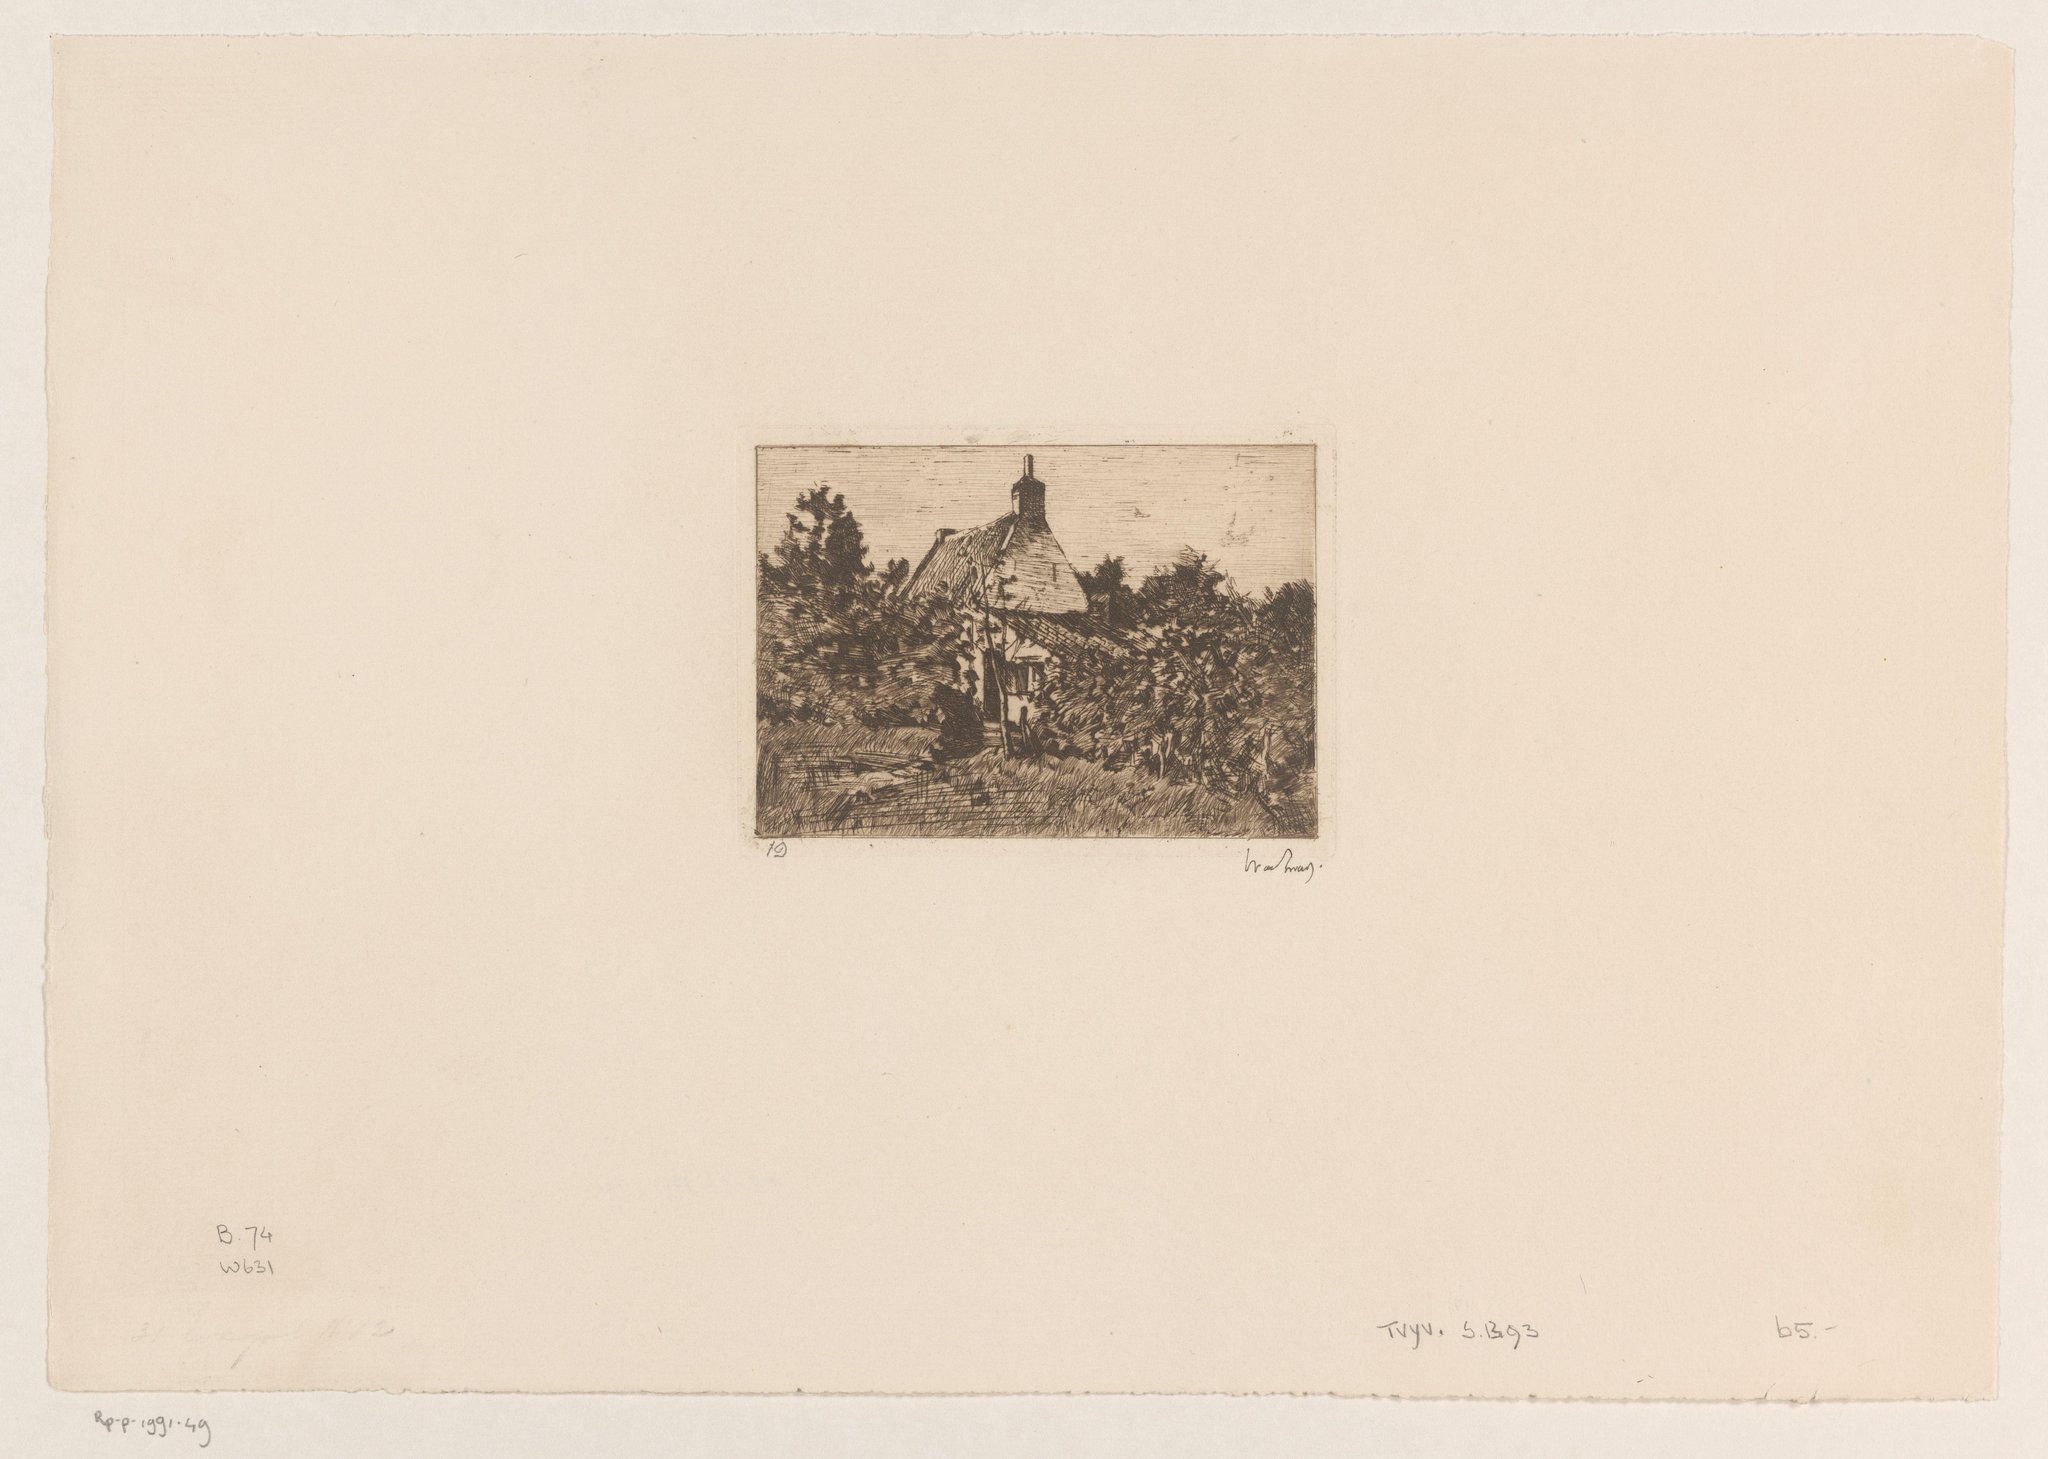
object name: print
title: Landschap met huis tussen bomen en planten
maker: willem de zwart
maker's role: draughtsman, painter, print maker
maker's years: 1862-1931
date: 1896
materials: paper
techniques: drypoint, etching, intaglio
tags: landscapes in the temperate zone, farm or solitary house in landscape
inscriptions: collector's mark: Lugt 2760, collector's mark: Lugt 2228